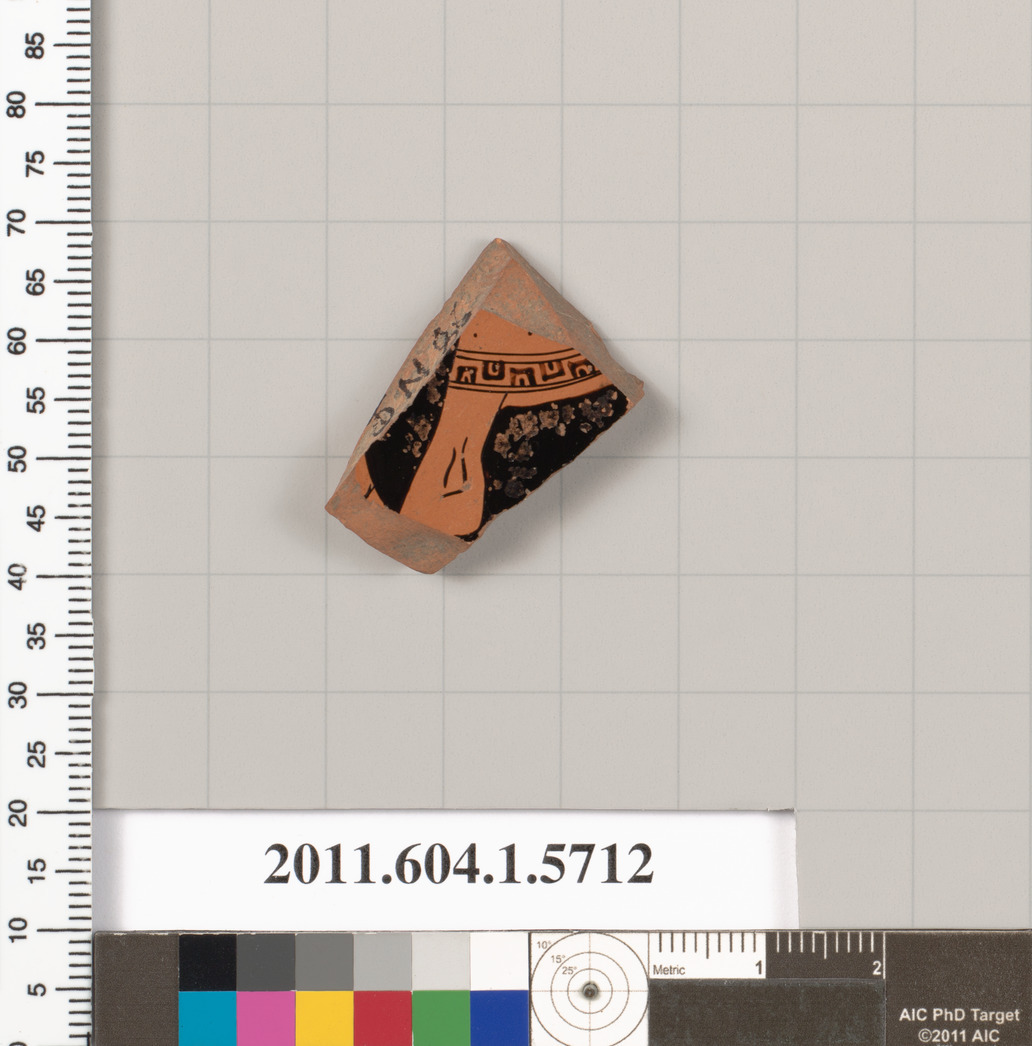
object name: kylix fragment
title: Terracotta fragment of a kylix (drinking cup)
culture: greek, attic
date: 500-480 BCE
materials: terracotta